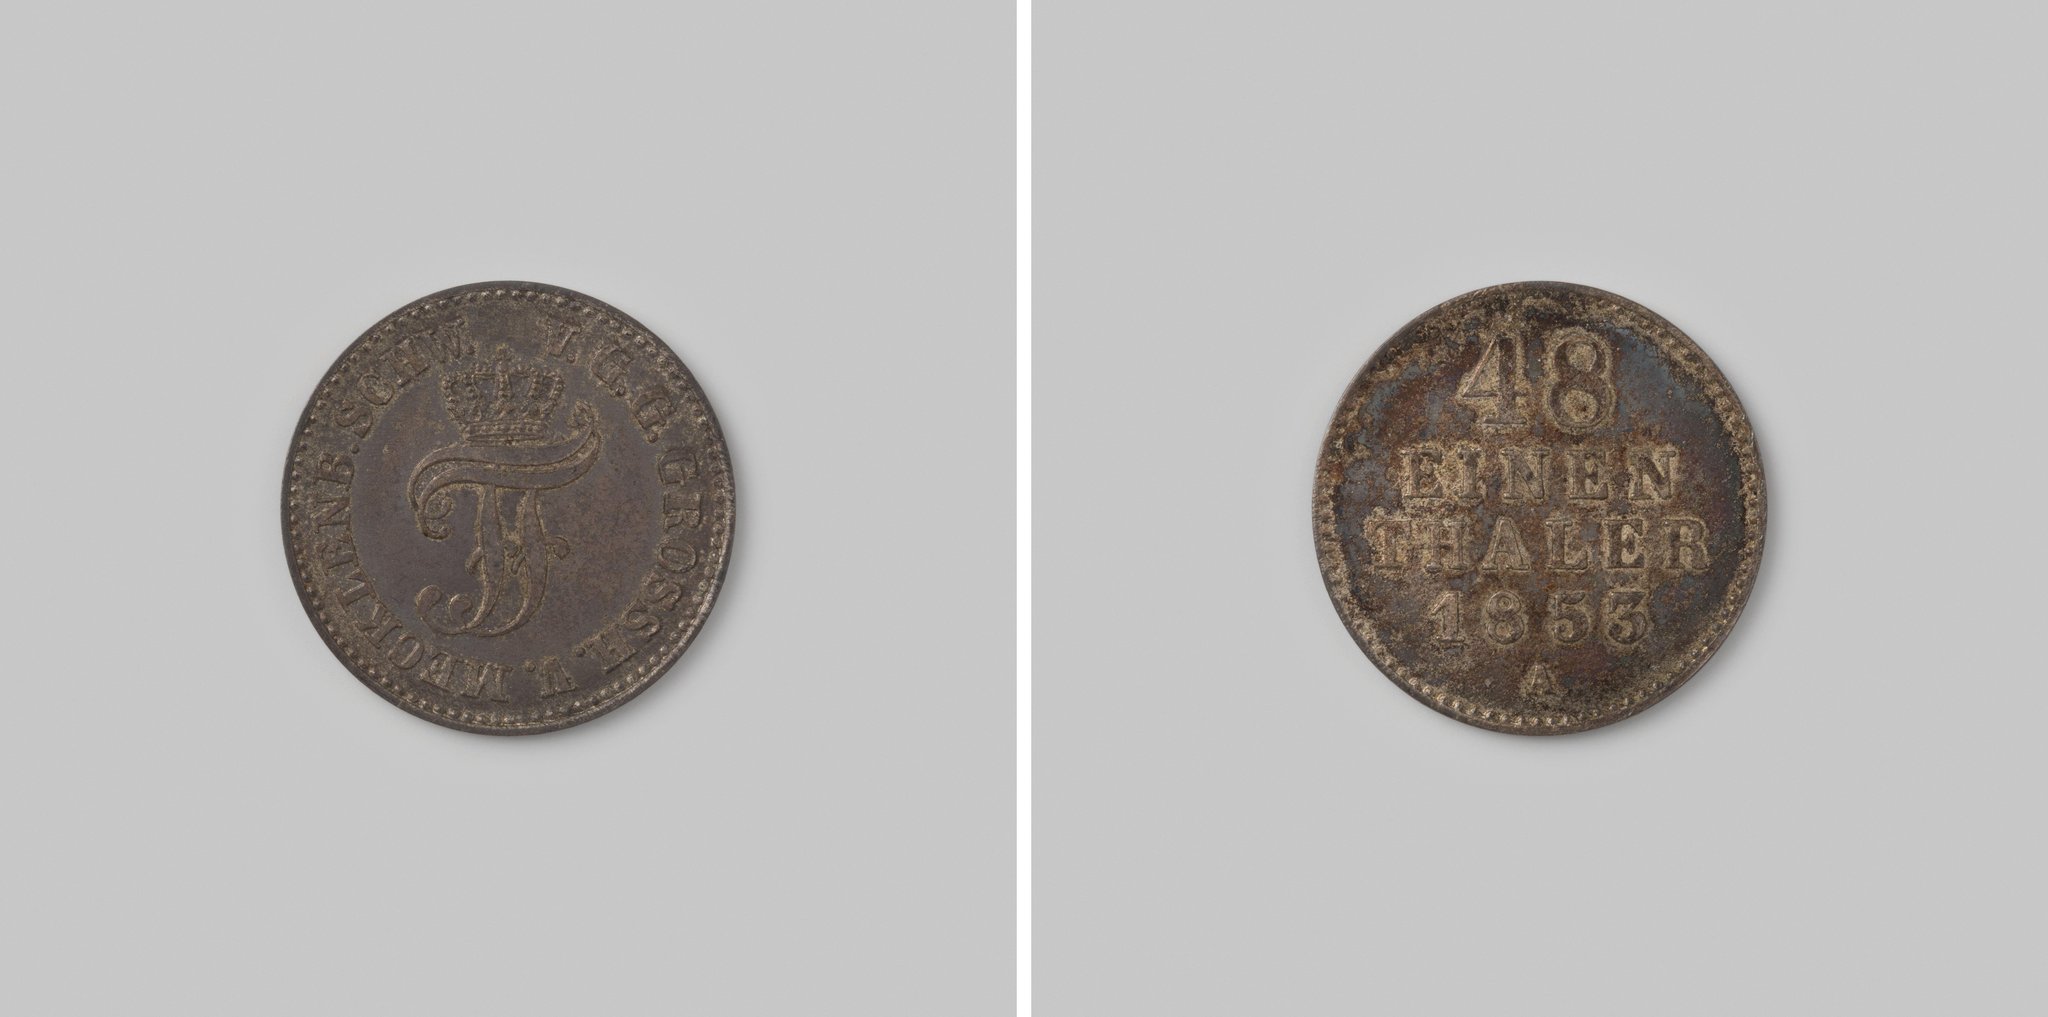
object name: achtenveertigste taler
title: Groothertogdom Mecklenburg-Schwerin, Friedrich Franz II, 1/48 taler, 1853 A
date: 1853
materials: silver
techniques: striking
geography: berlin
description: Zilveren munt. Voorzijde: gekroond monogram van de groothertog. Keerzijde: waarde-aanduiding in drie regels, waaronder jaartal. Daaronder letter A. Gladde rand.